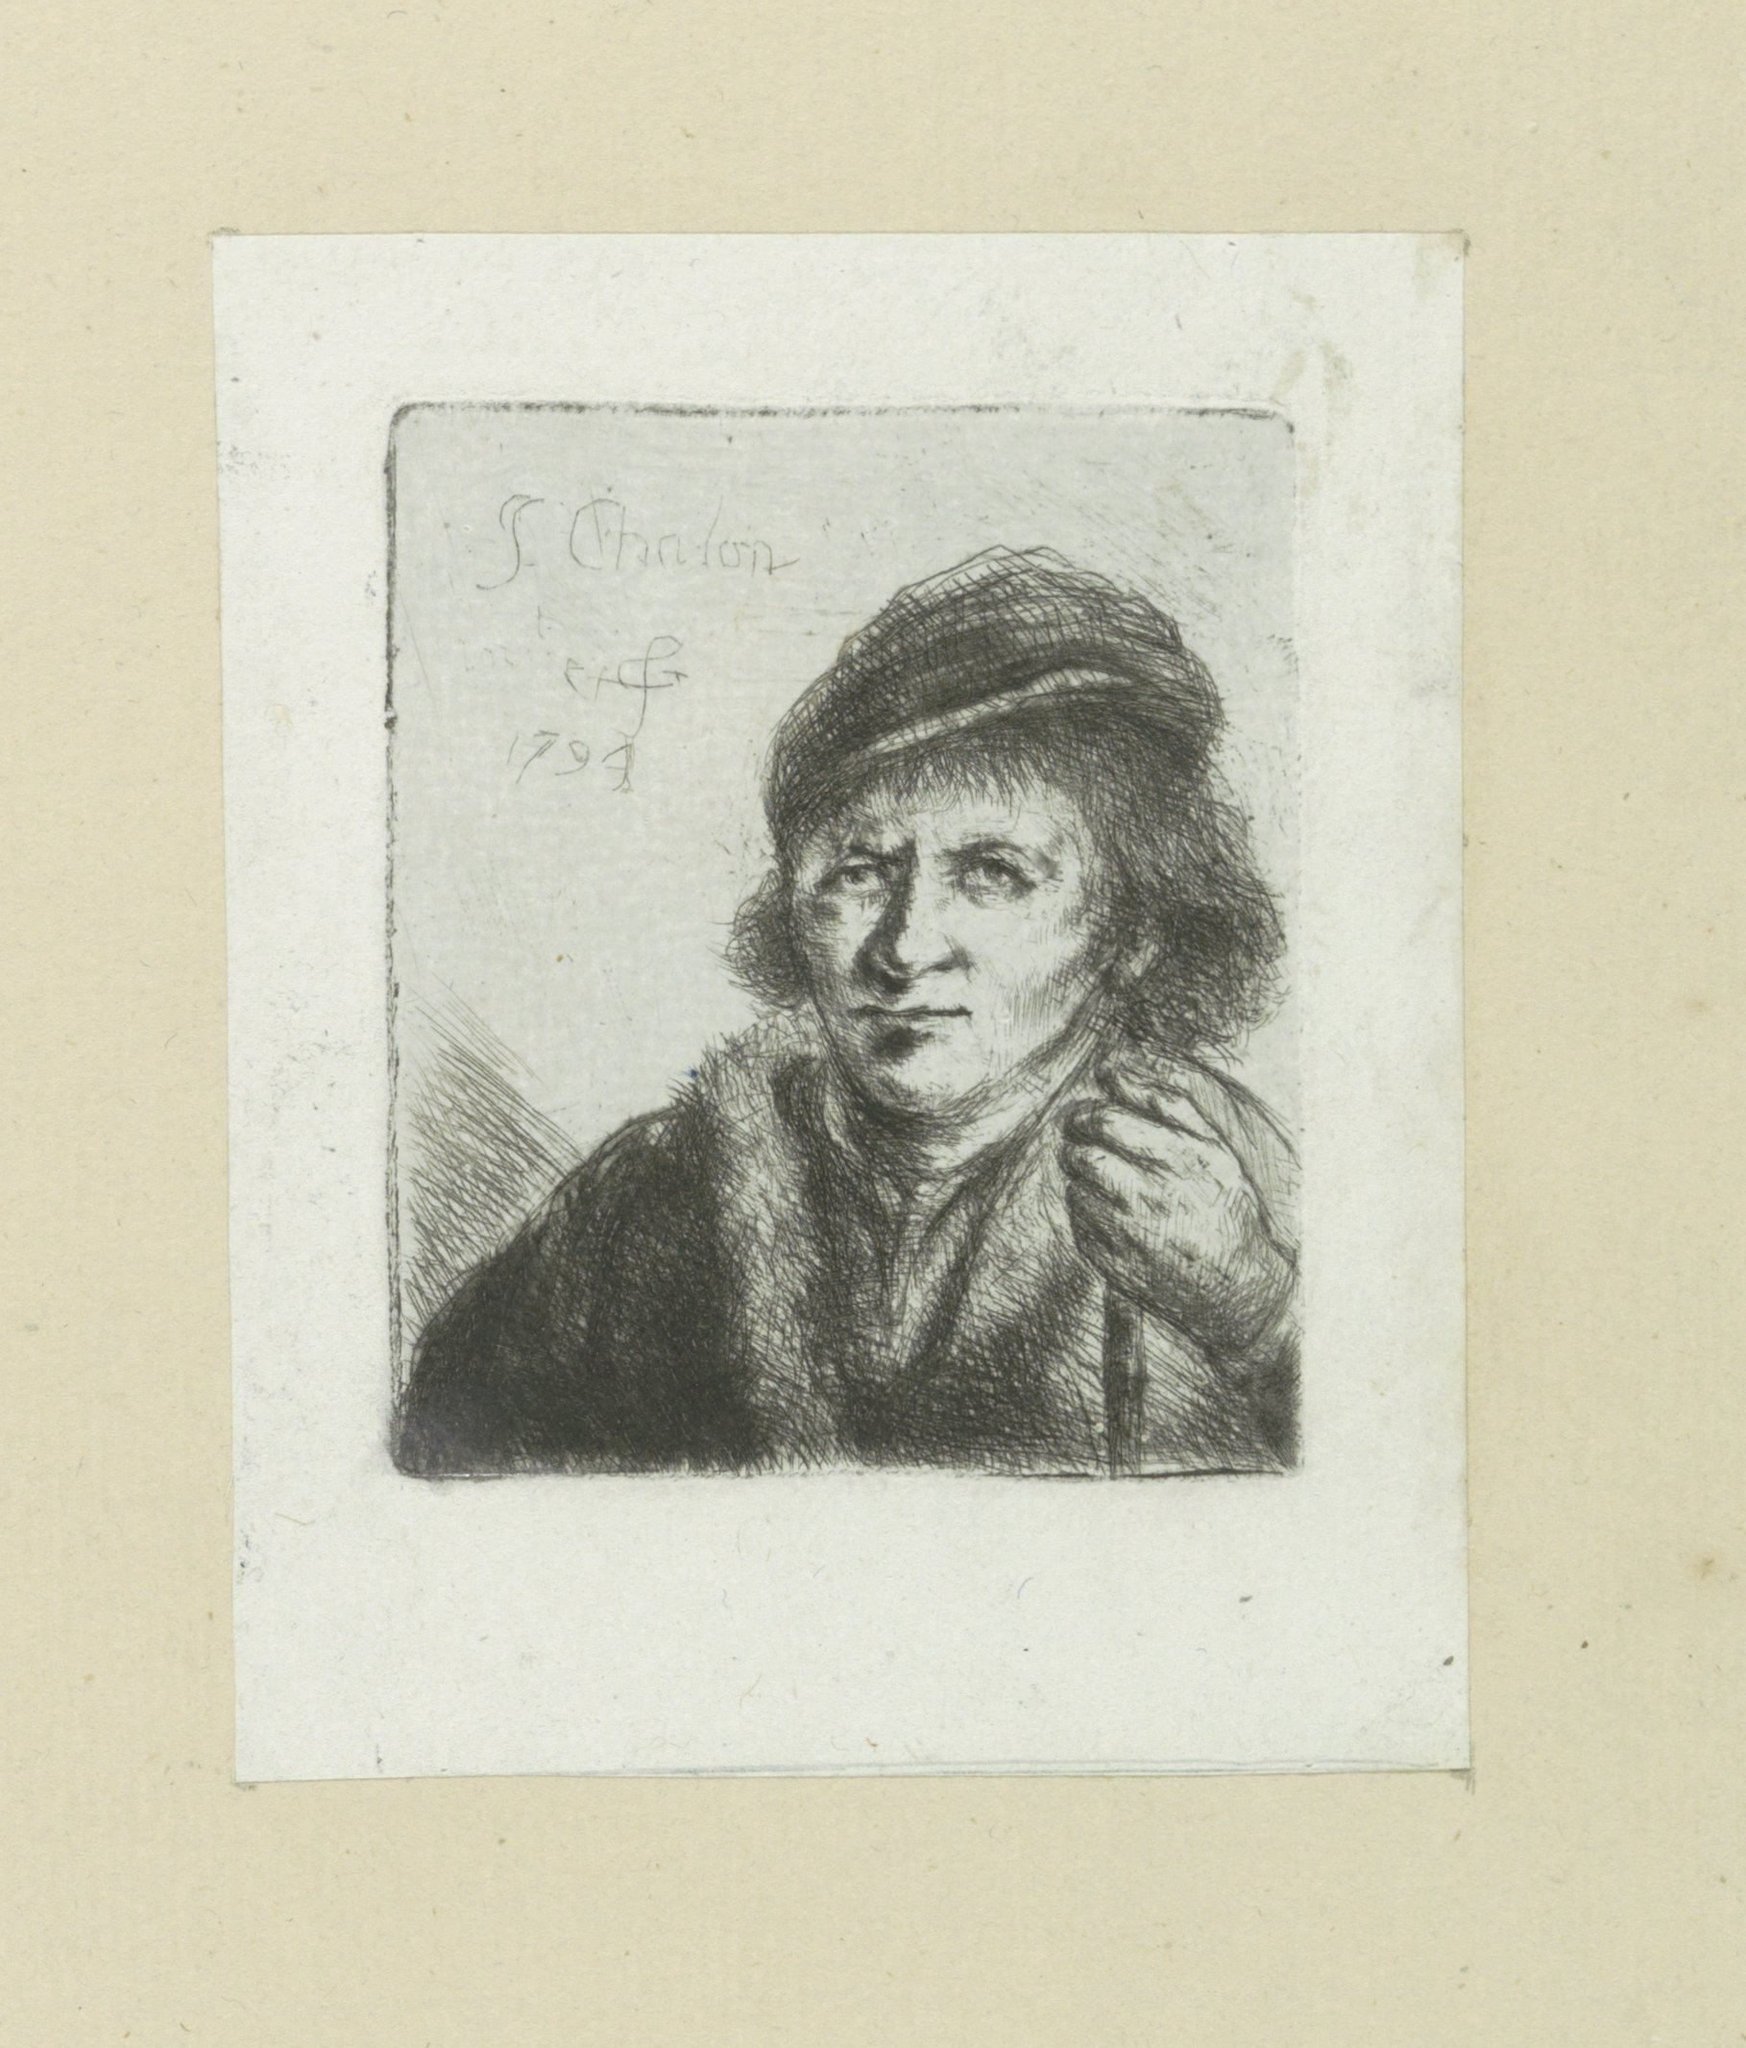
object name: print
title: Volwassen man met hoed en stok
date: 1794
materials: paper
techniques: drypoint, etching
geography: london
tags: head-gear: cap (+ men's clothes), morphology of human expression (+ adult male (human being))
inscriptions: collector's mark: ‘RIJKS / MUSM’, collector's mark: ‘B’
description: Een volwassen man met hoed. Over zijn rechter schouder een mantel. In zijn linkerhand een stok. De prent maakt deel uit van een album.